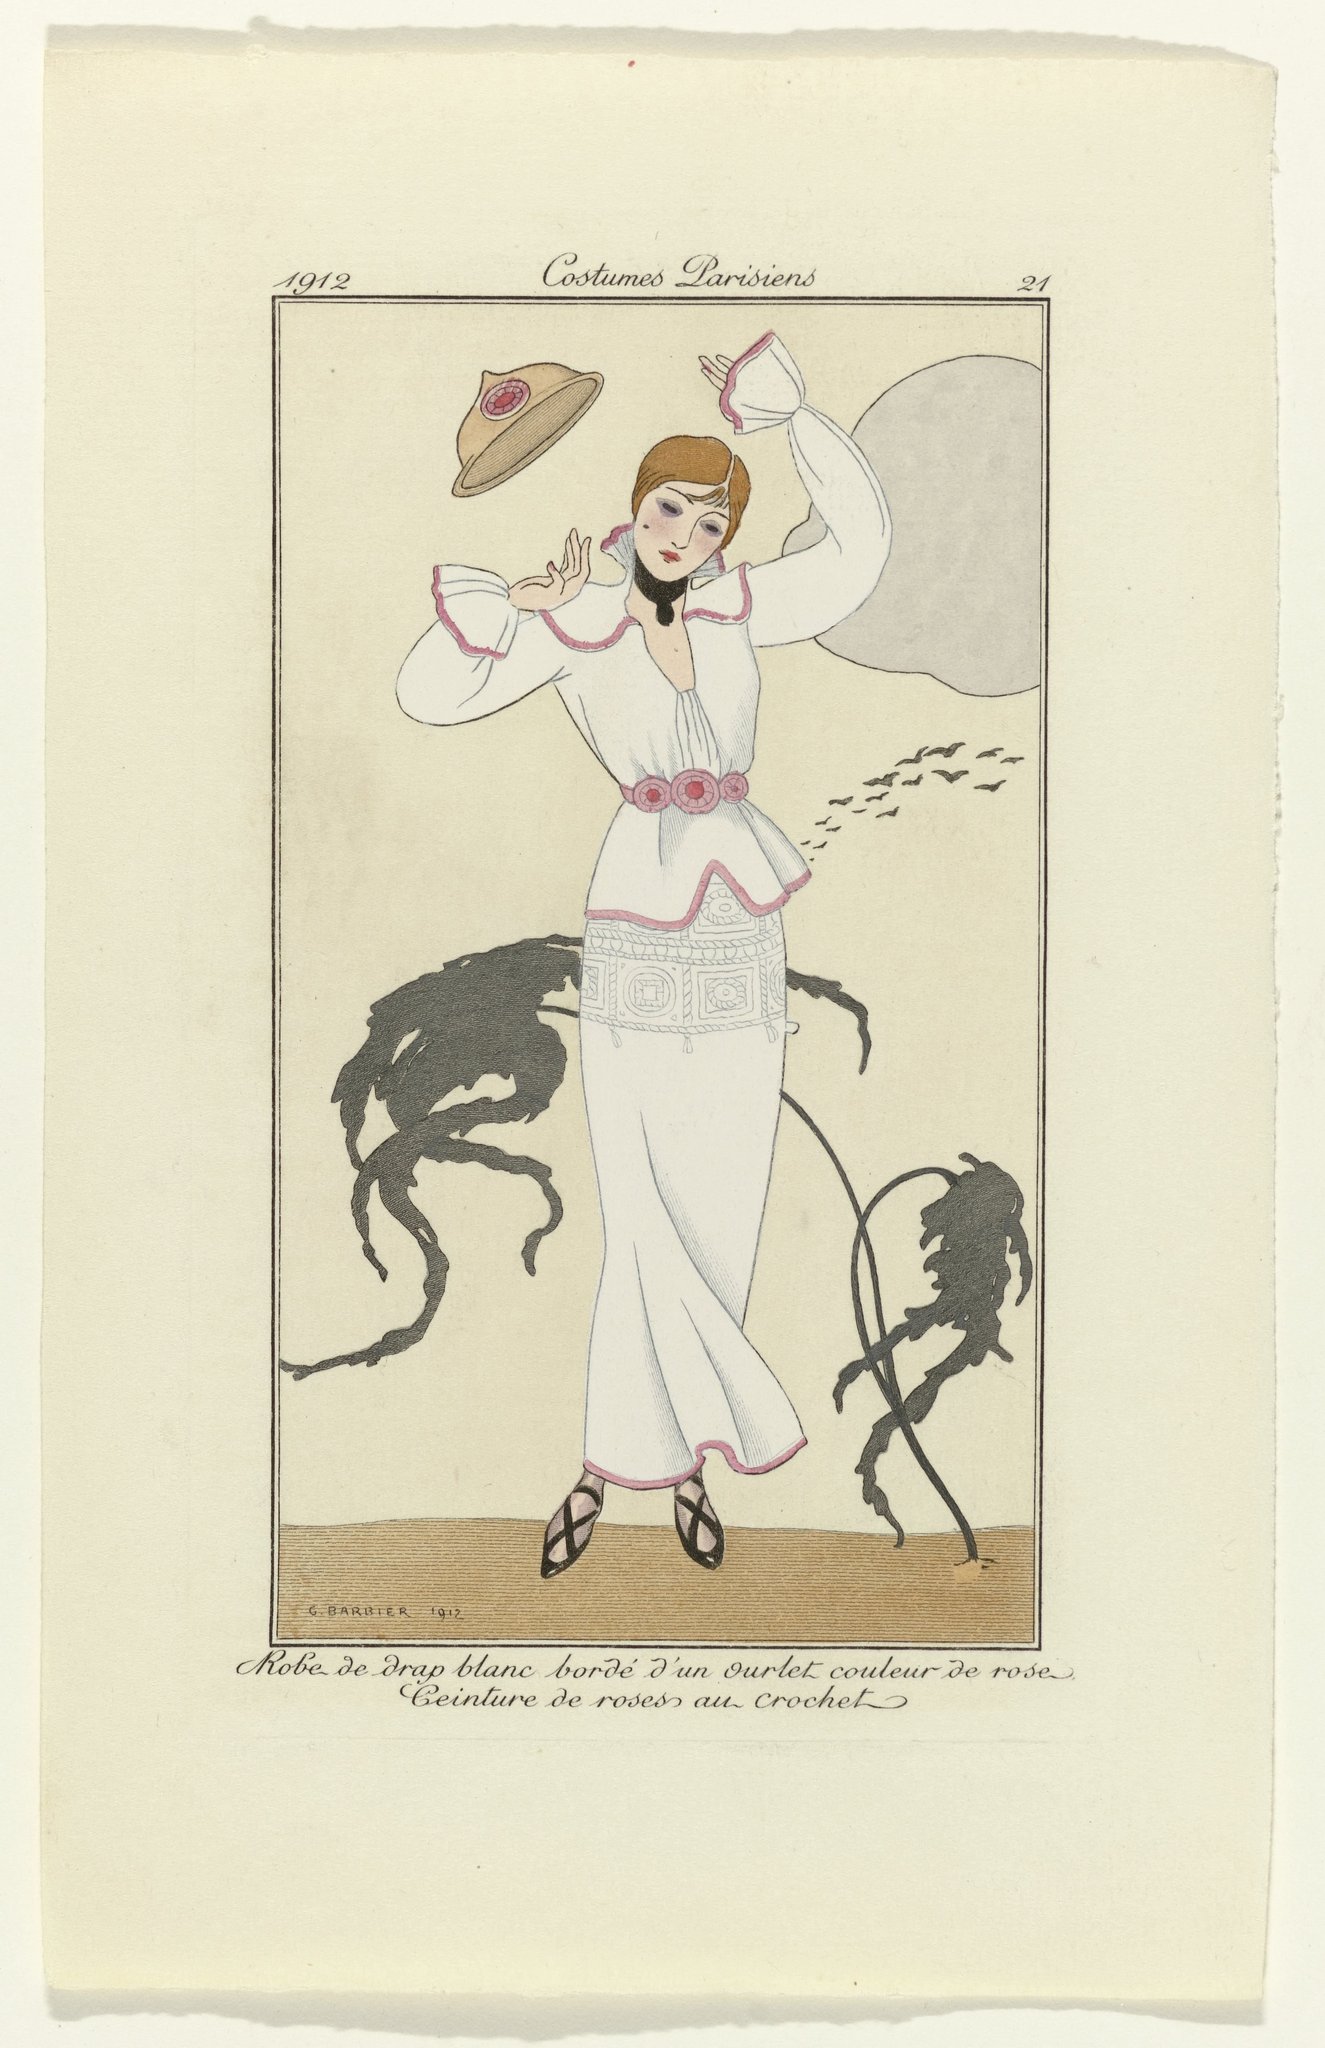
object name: fashion print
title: Journal des Dames et des Modes, 1912, Costumes Parisiens, no. 21: Robe de drap blanc (...)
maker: george barbier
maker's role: designer, draughtsman, painter, print maker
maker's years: 1882-1932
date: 1912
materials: paper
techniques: engraving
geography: paris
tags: fashion plates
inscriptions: caption: ‘Robe de promenade en Sarah à damiers et taffetas peint à la main, bordée de velours noir: Chapeau de paille orné d'un panache en duvet de Cygne’